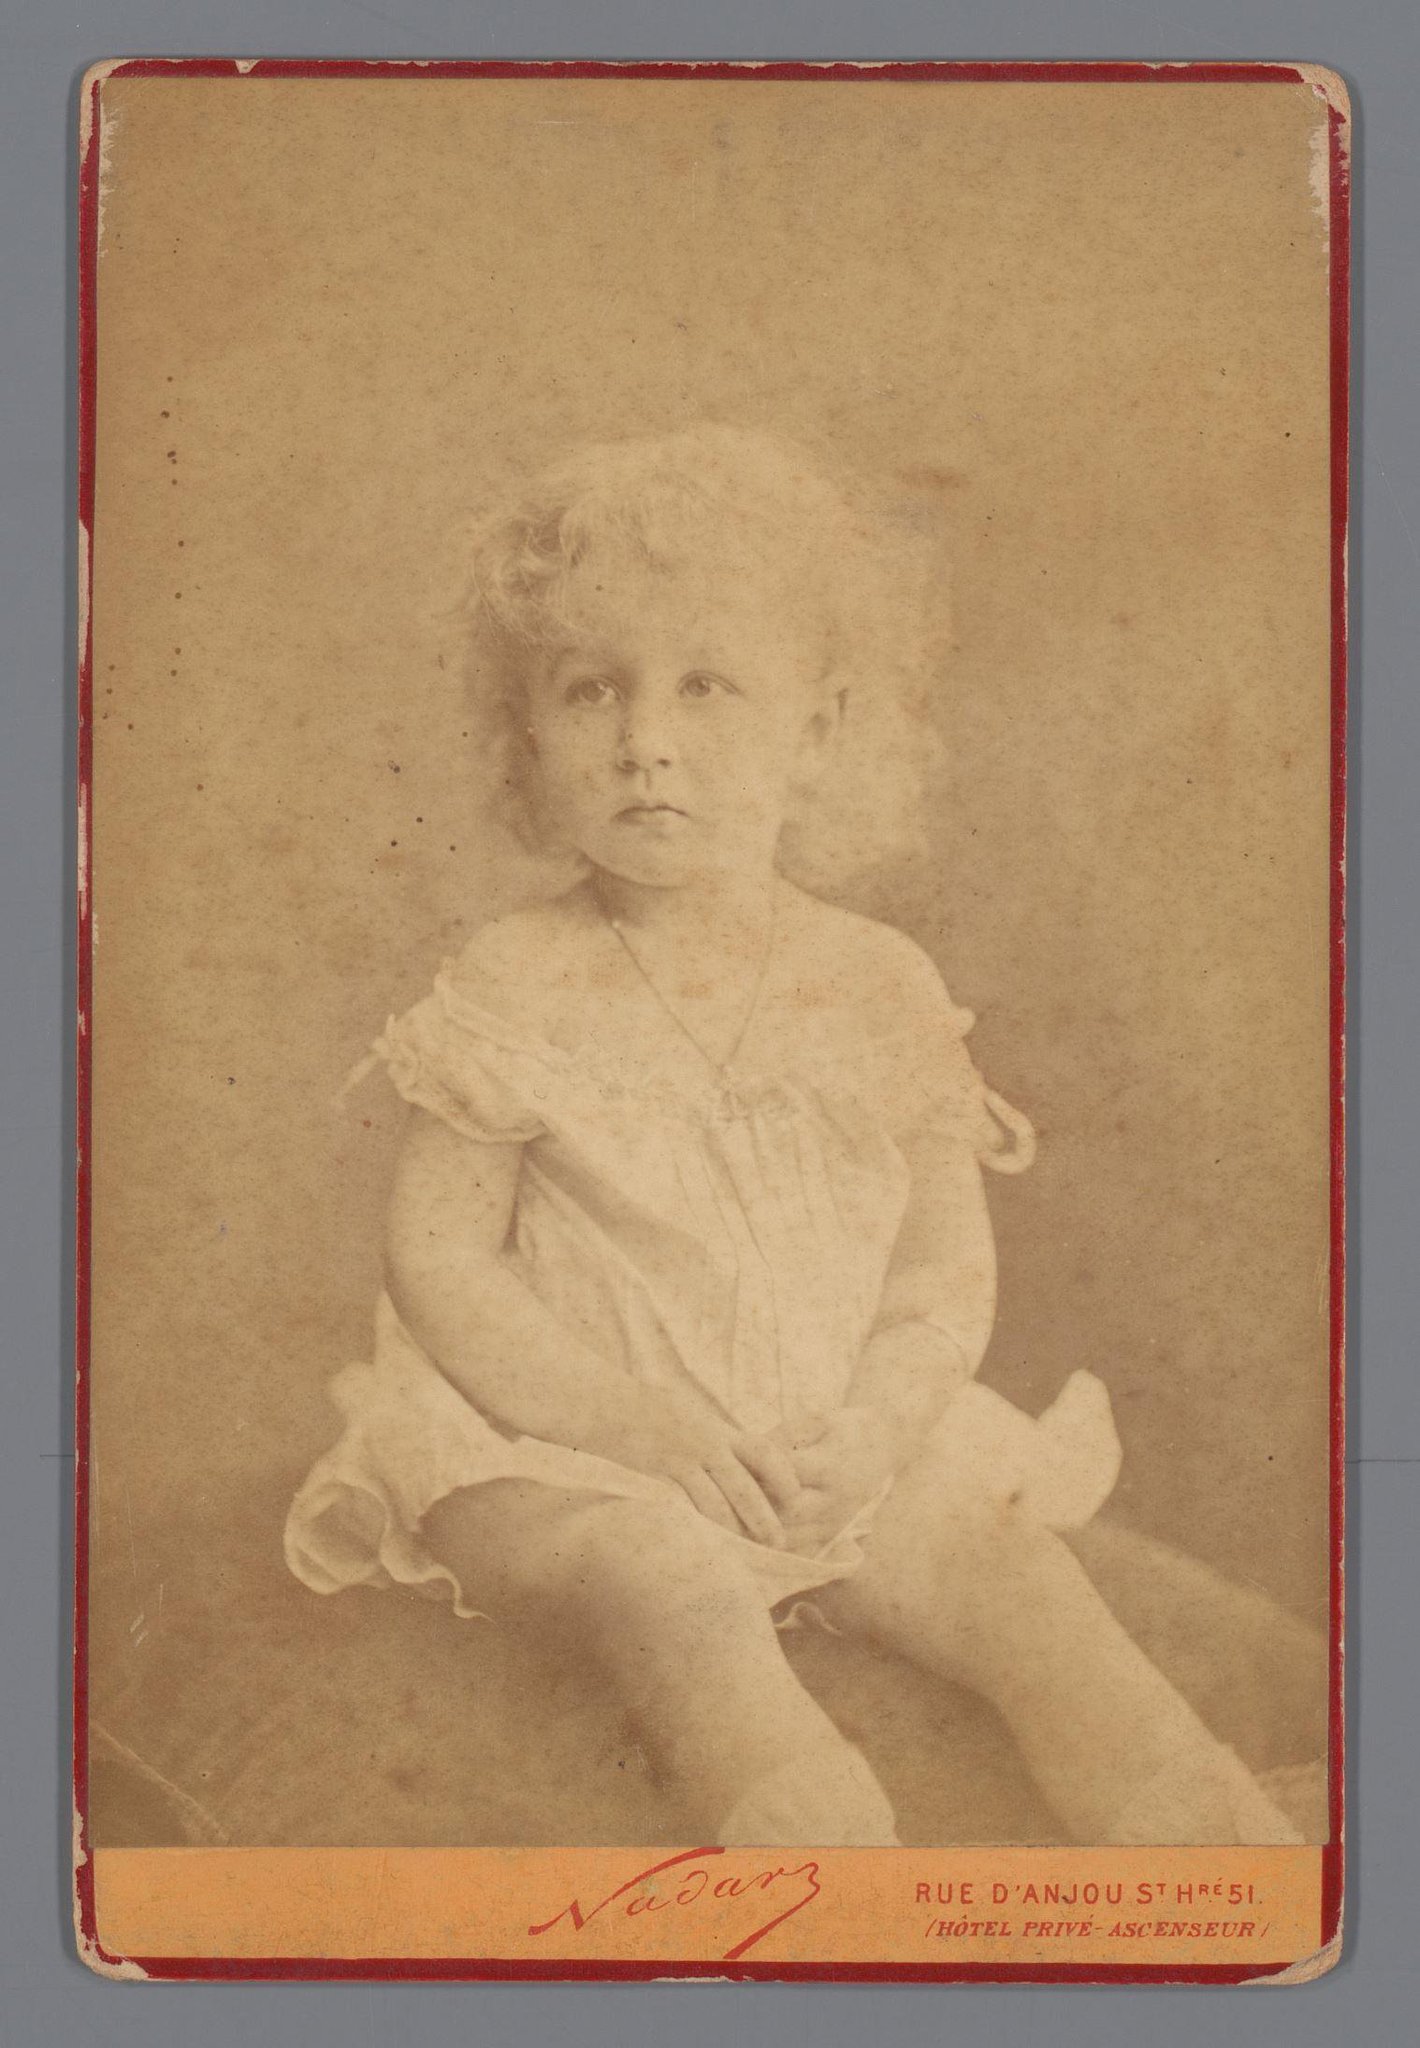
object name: photograph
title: Studioportret van een jong meisje, zittend op een kussen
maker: félix nadar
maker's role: ballonvaarder, fotograaf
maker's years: 1820-1910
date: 1878-1890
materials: cardboard, photographic support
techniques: albumen print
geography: paris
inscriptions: caption: ‘Nadar Rue d'Anjou St Hre 51.//(Hôtel Privé-Ascenseur)’, number: ‘1097’, stamp: ‘MEDAILLE D'OR//EXPOSITION UNIVERSELLE 1878//NADAR//RUE D'ANJOU ST HONORÉ, 51.//a l'Angle de la Chapelle Expiatoire Be (?) Haussmann//(HÔTEL PRIVÉ-ASCENSEUR)//PARIS//(Anciennement Boulevard des Capucines)’, annotation: ‘f 357’, number: ‘II’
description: Studioportret van een jong meisje, zittend op een kussen.